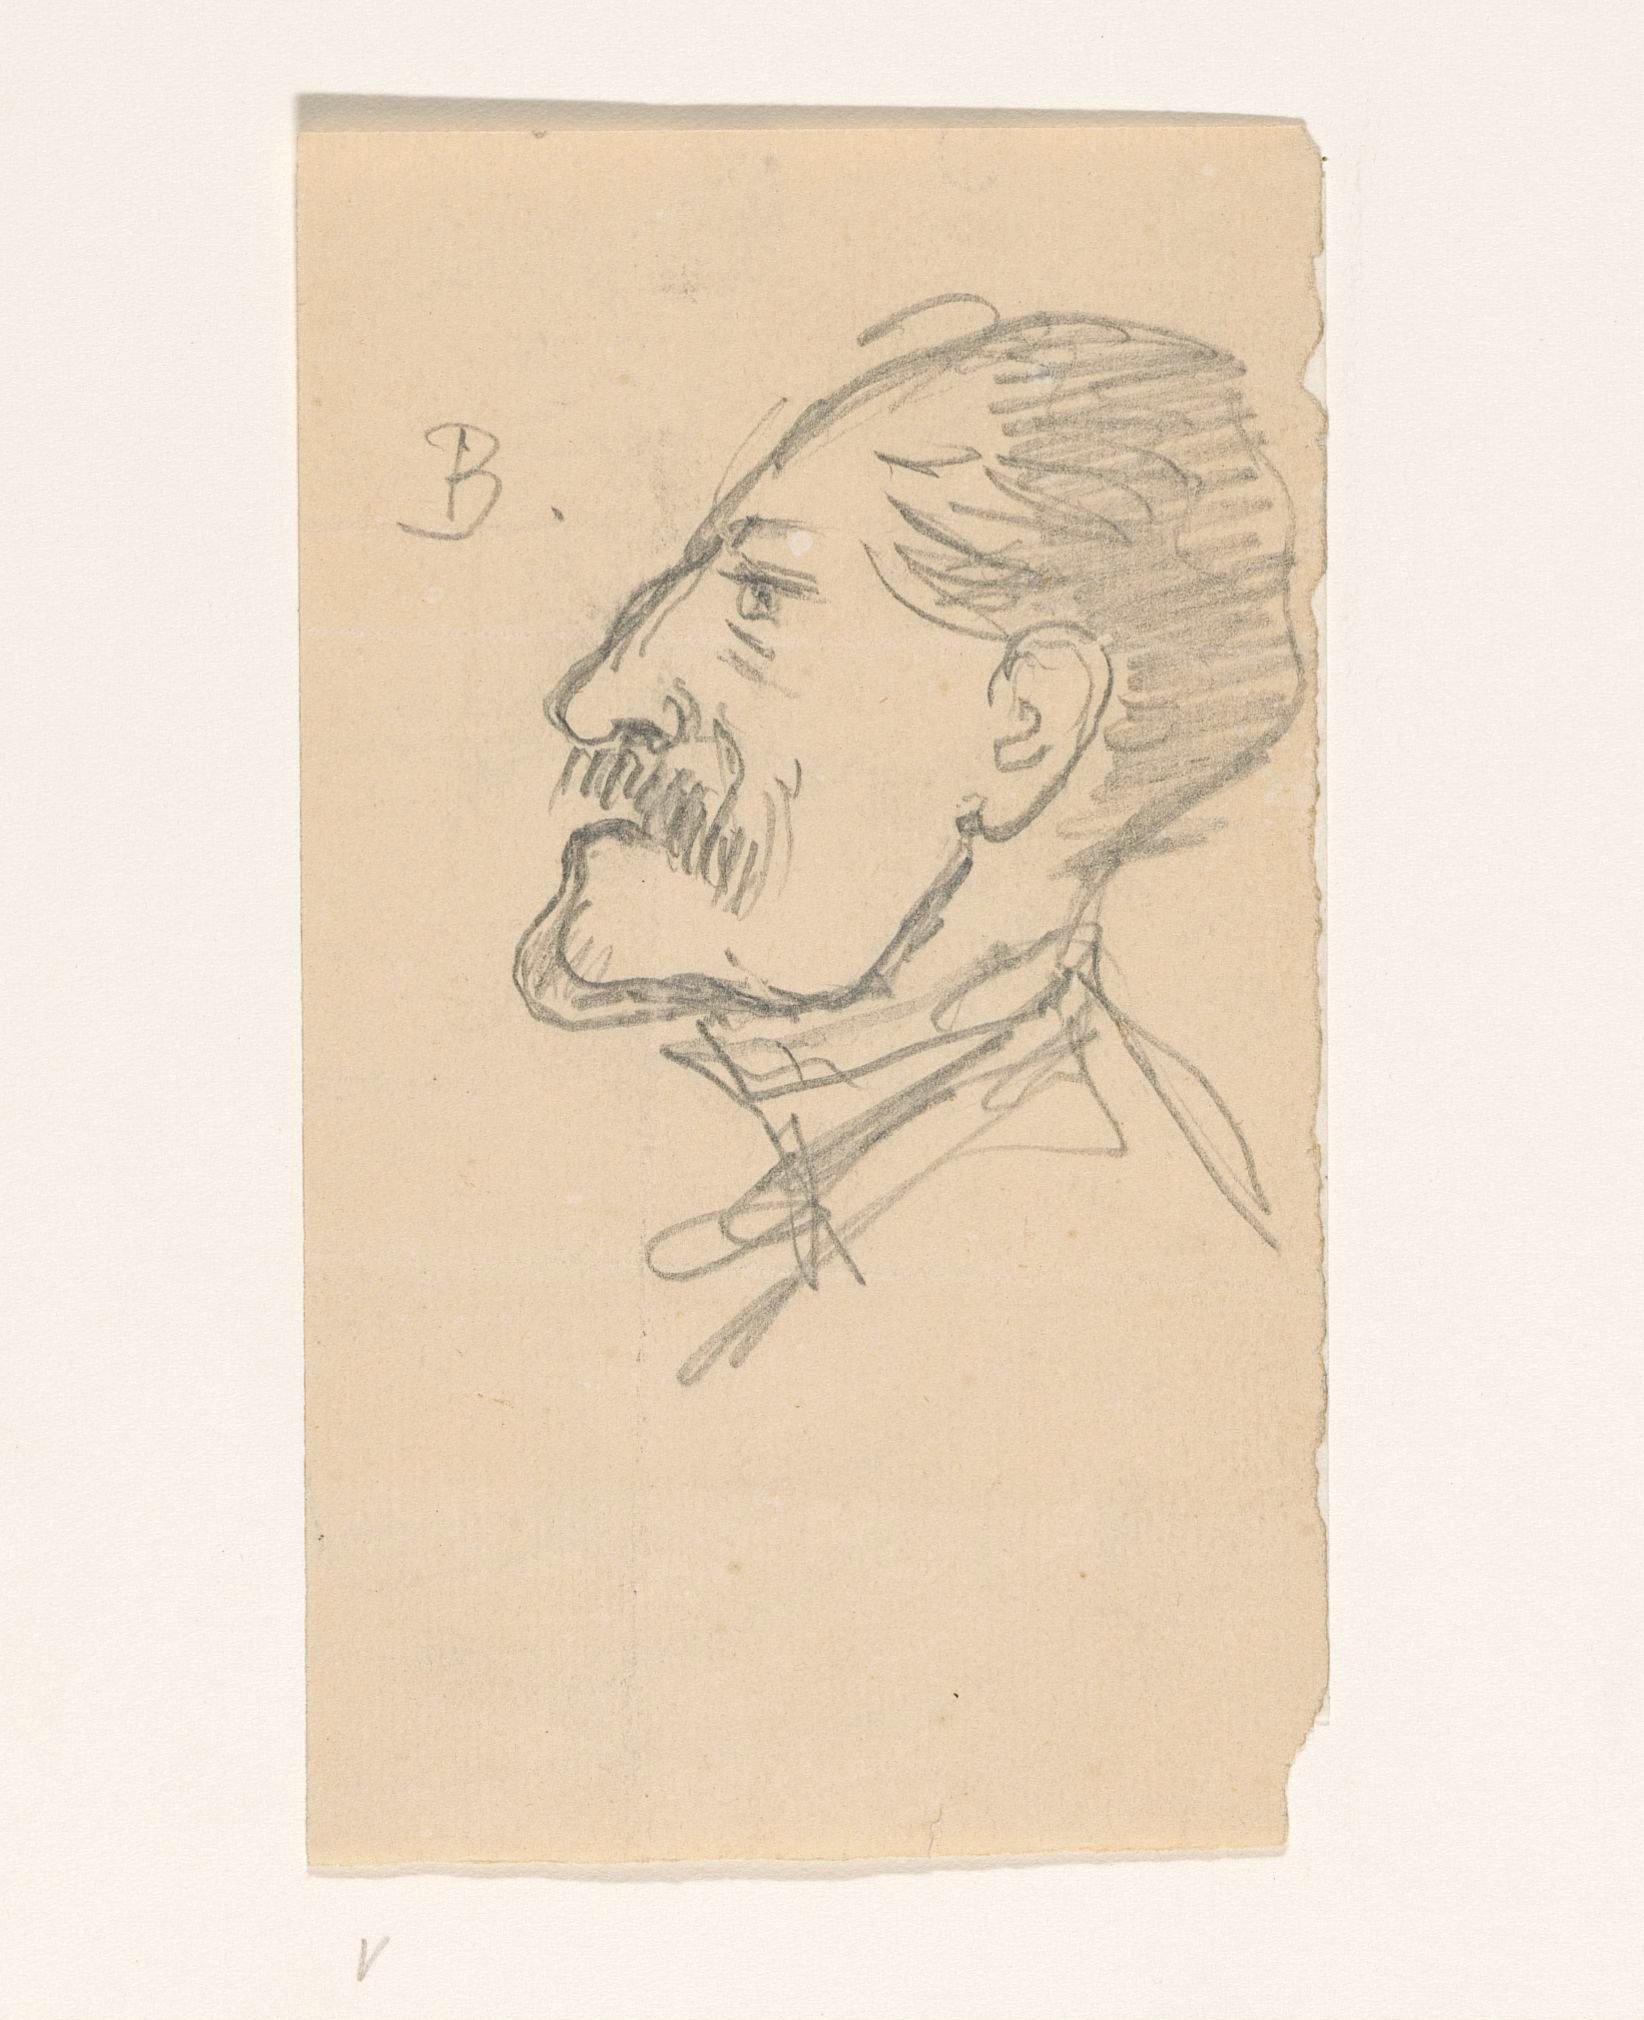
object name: drawing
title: Portret van onbekende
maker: johan michaël schmidt crans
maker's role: draughtsman, print maker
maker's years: 1830-1907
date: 1875-1895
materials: paper, pencil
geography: netherlands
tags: historical persons not known by name, netherlands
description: Schets van een onbekende man, waarschijnlijk een kamerlid. Mogelijk een voorstudie voor een politieke spotprent in De Uilenspiegel. Opschrift 'B'. Op de verso een schets met figuren.